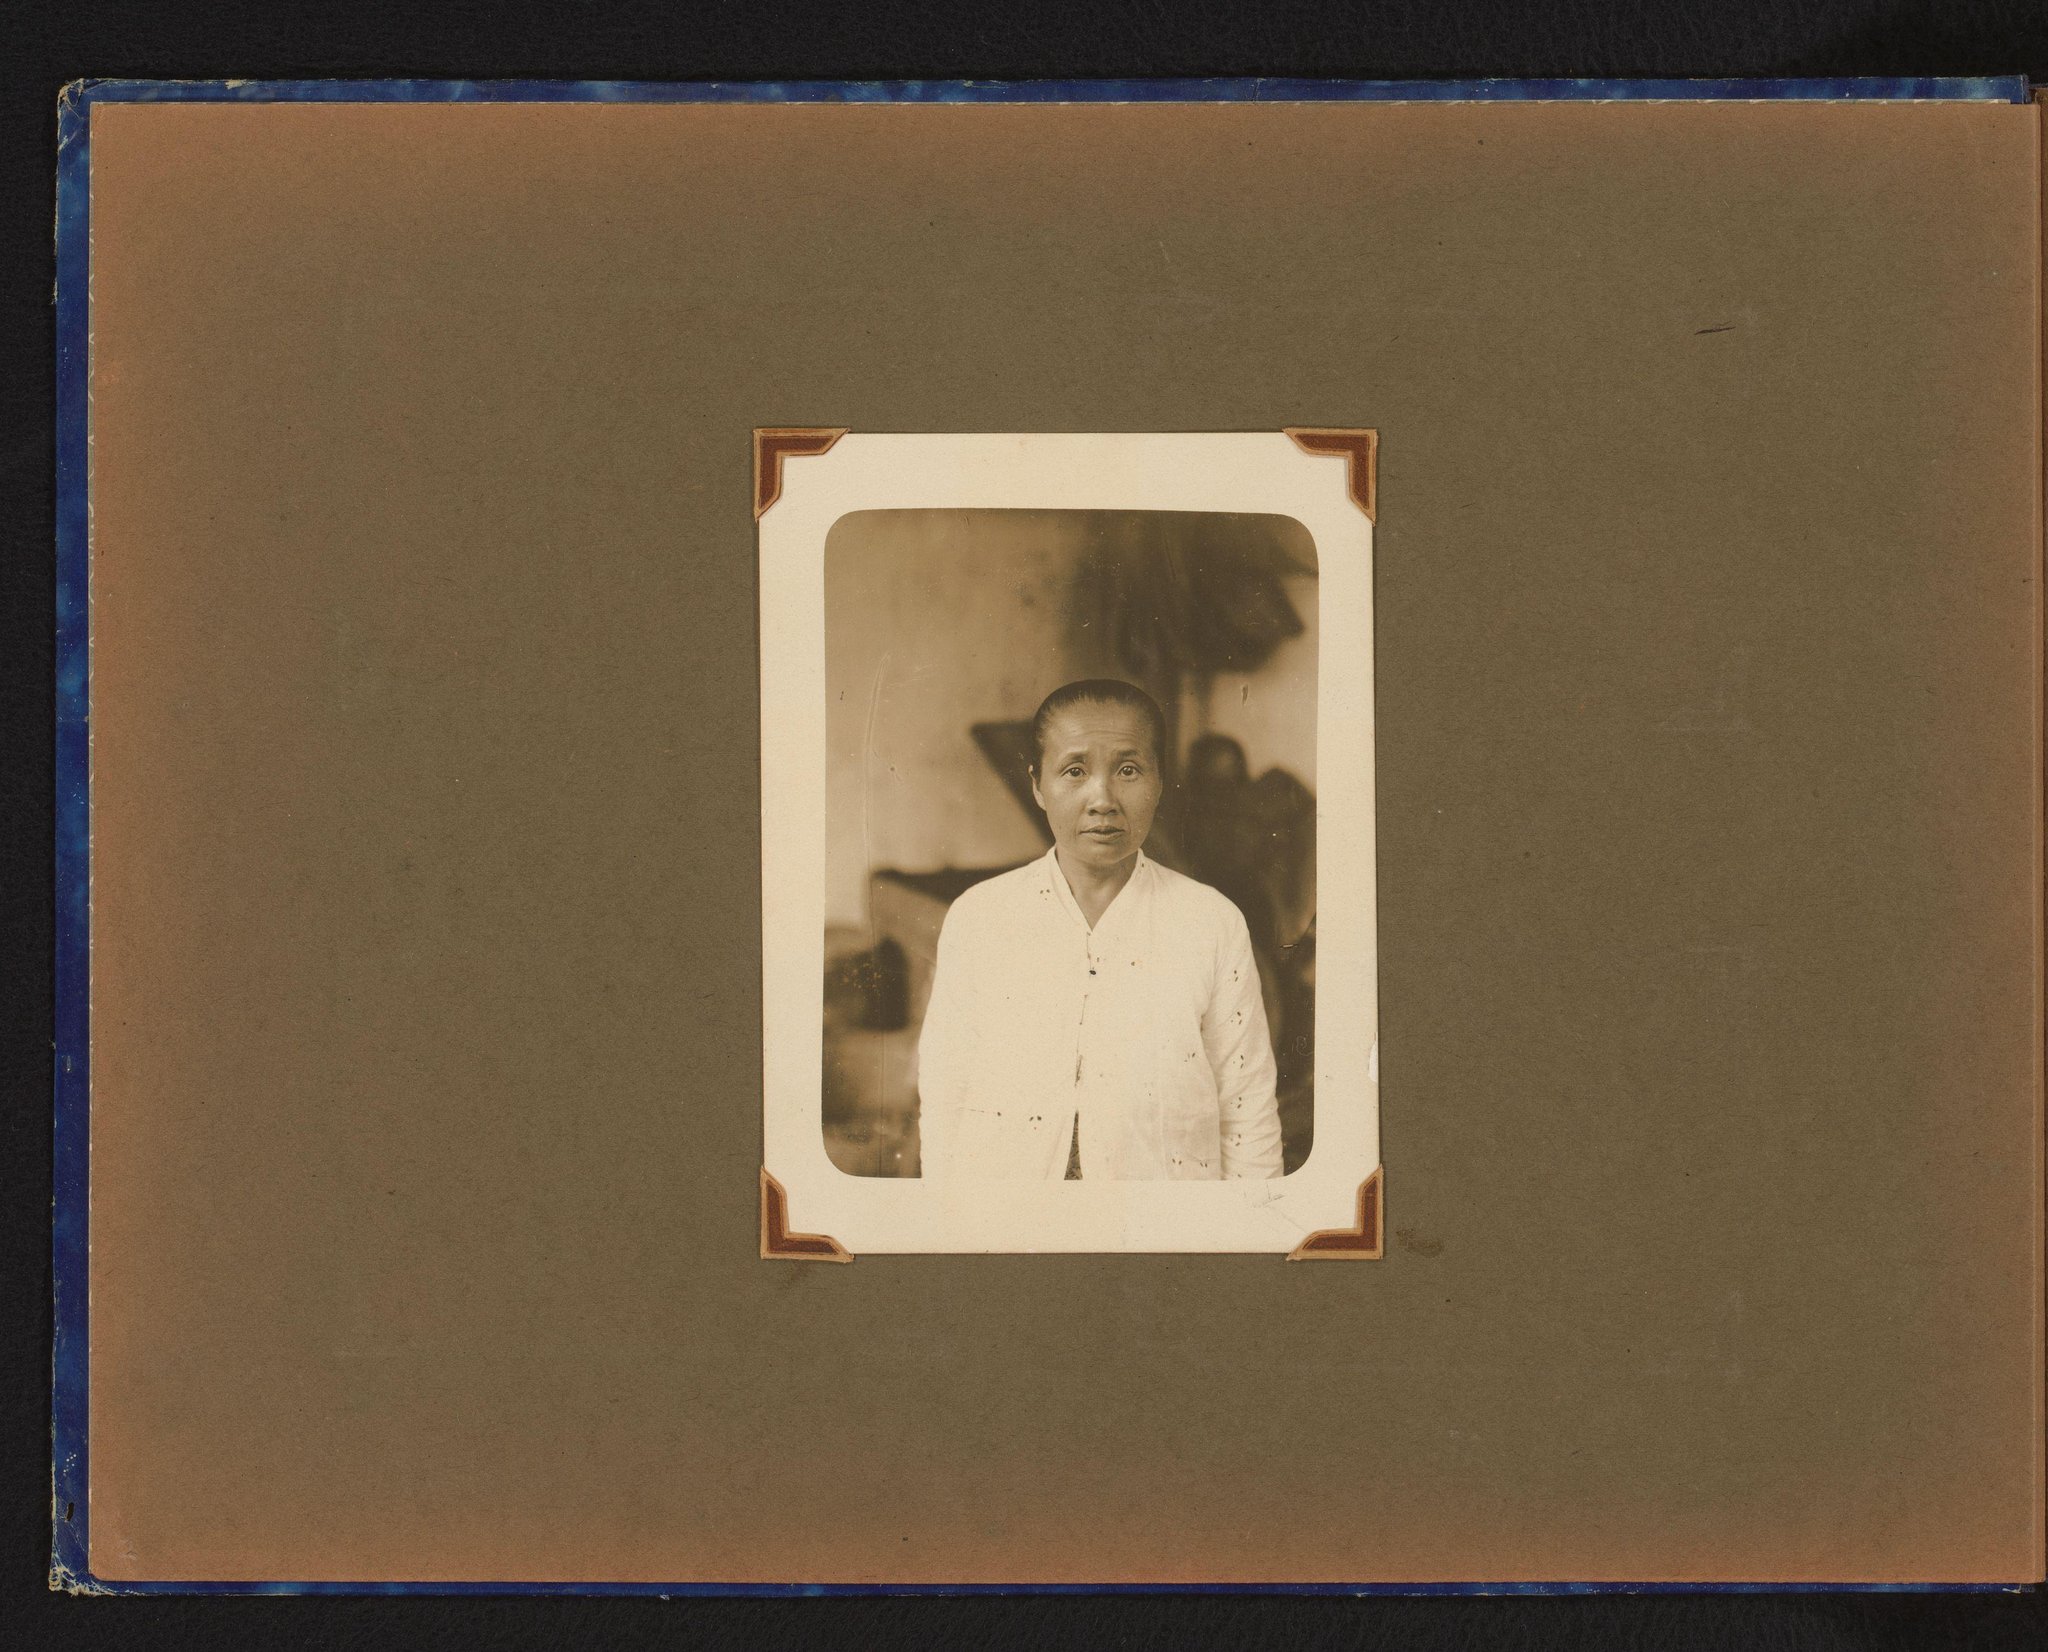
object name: photograph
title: Portret van een vrouw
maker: Anonymous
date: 1935-1936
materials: cardboard, photographic support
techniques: collodion silver print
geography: weltevreden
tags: historical persons not known by name - bb - woman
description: Albumblad met een foto van een onbekende vrouw. Onderdeel van een familiealbum van een Chinees-Indische familie in Weltevreden, ca. 1935.